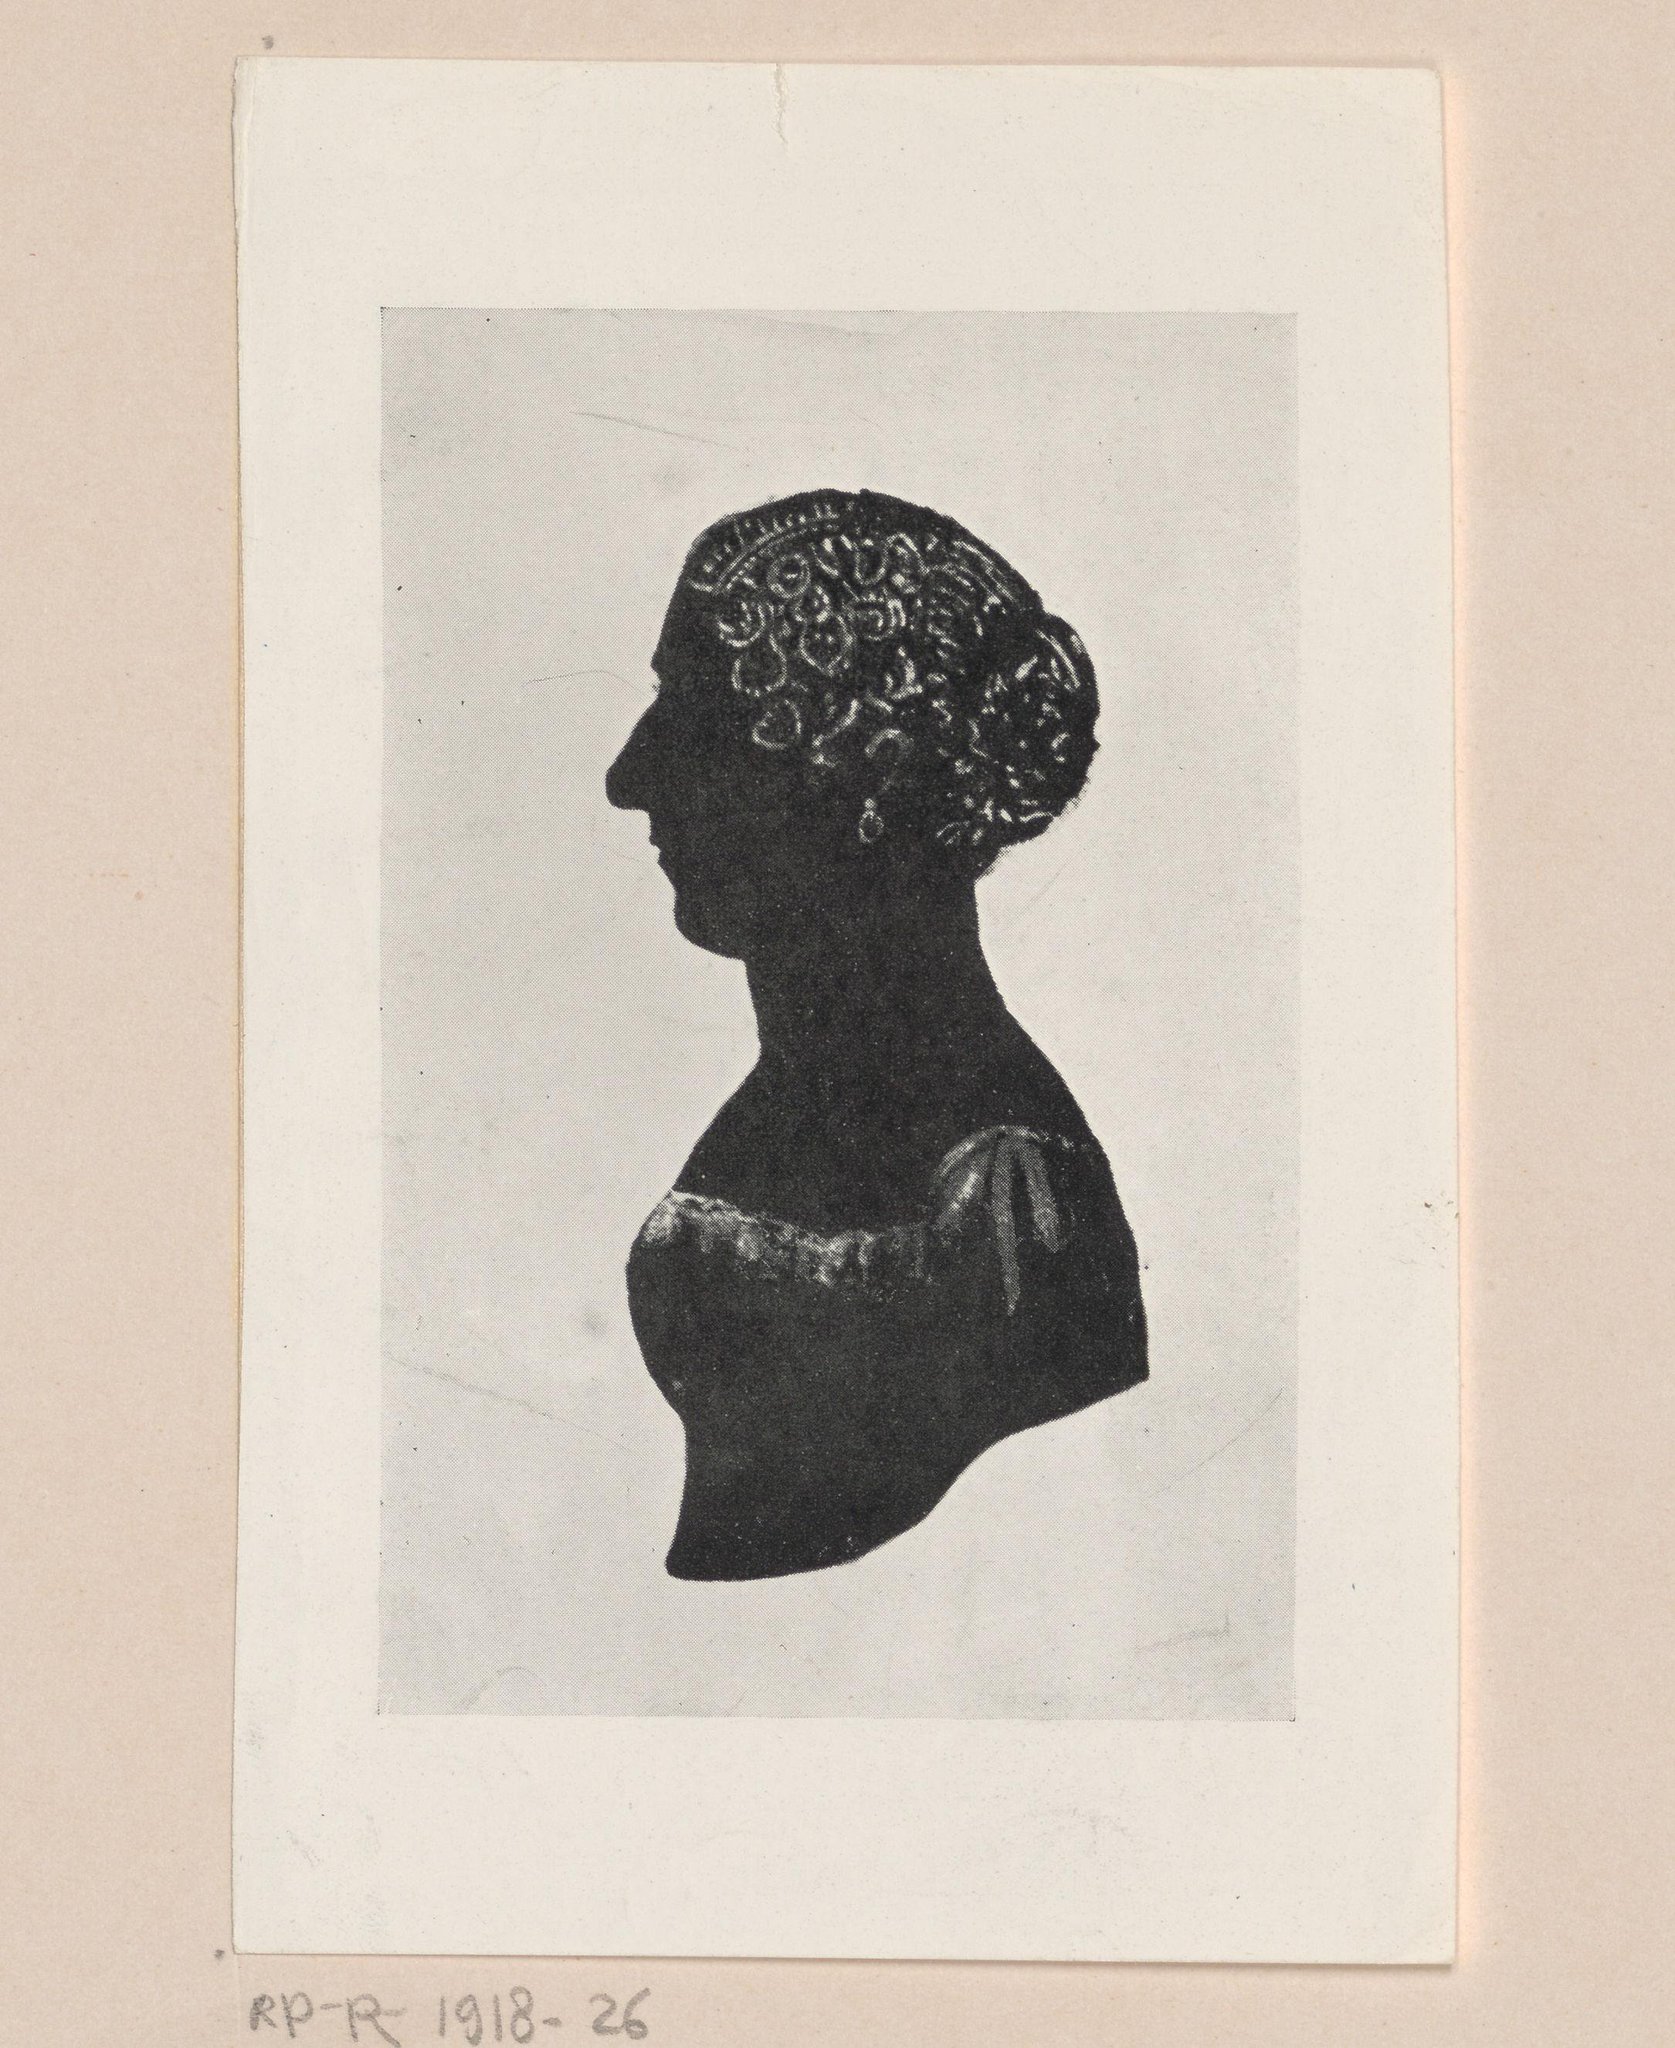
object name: photomechanical print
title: Silhouetportret van Wilhelmina Cornelia Maas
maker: Anonymous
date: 1895-1950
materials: paper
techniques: autotype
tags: historical persons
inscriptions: collector's mark: Lugt 2228